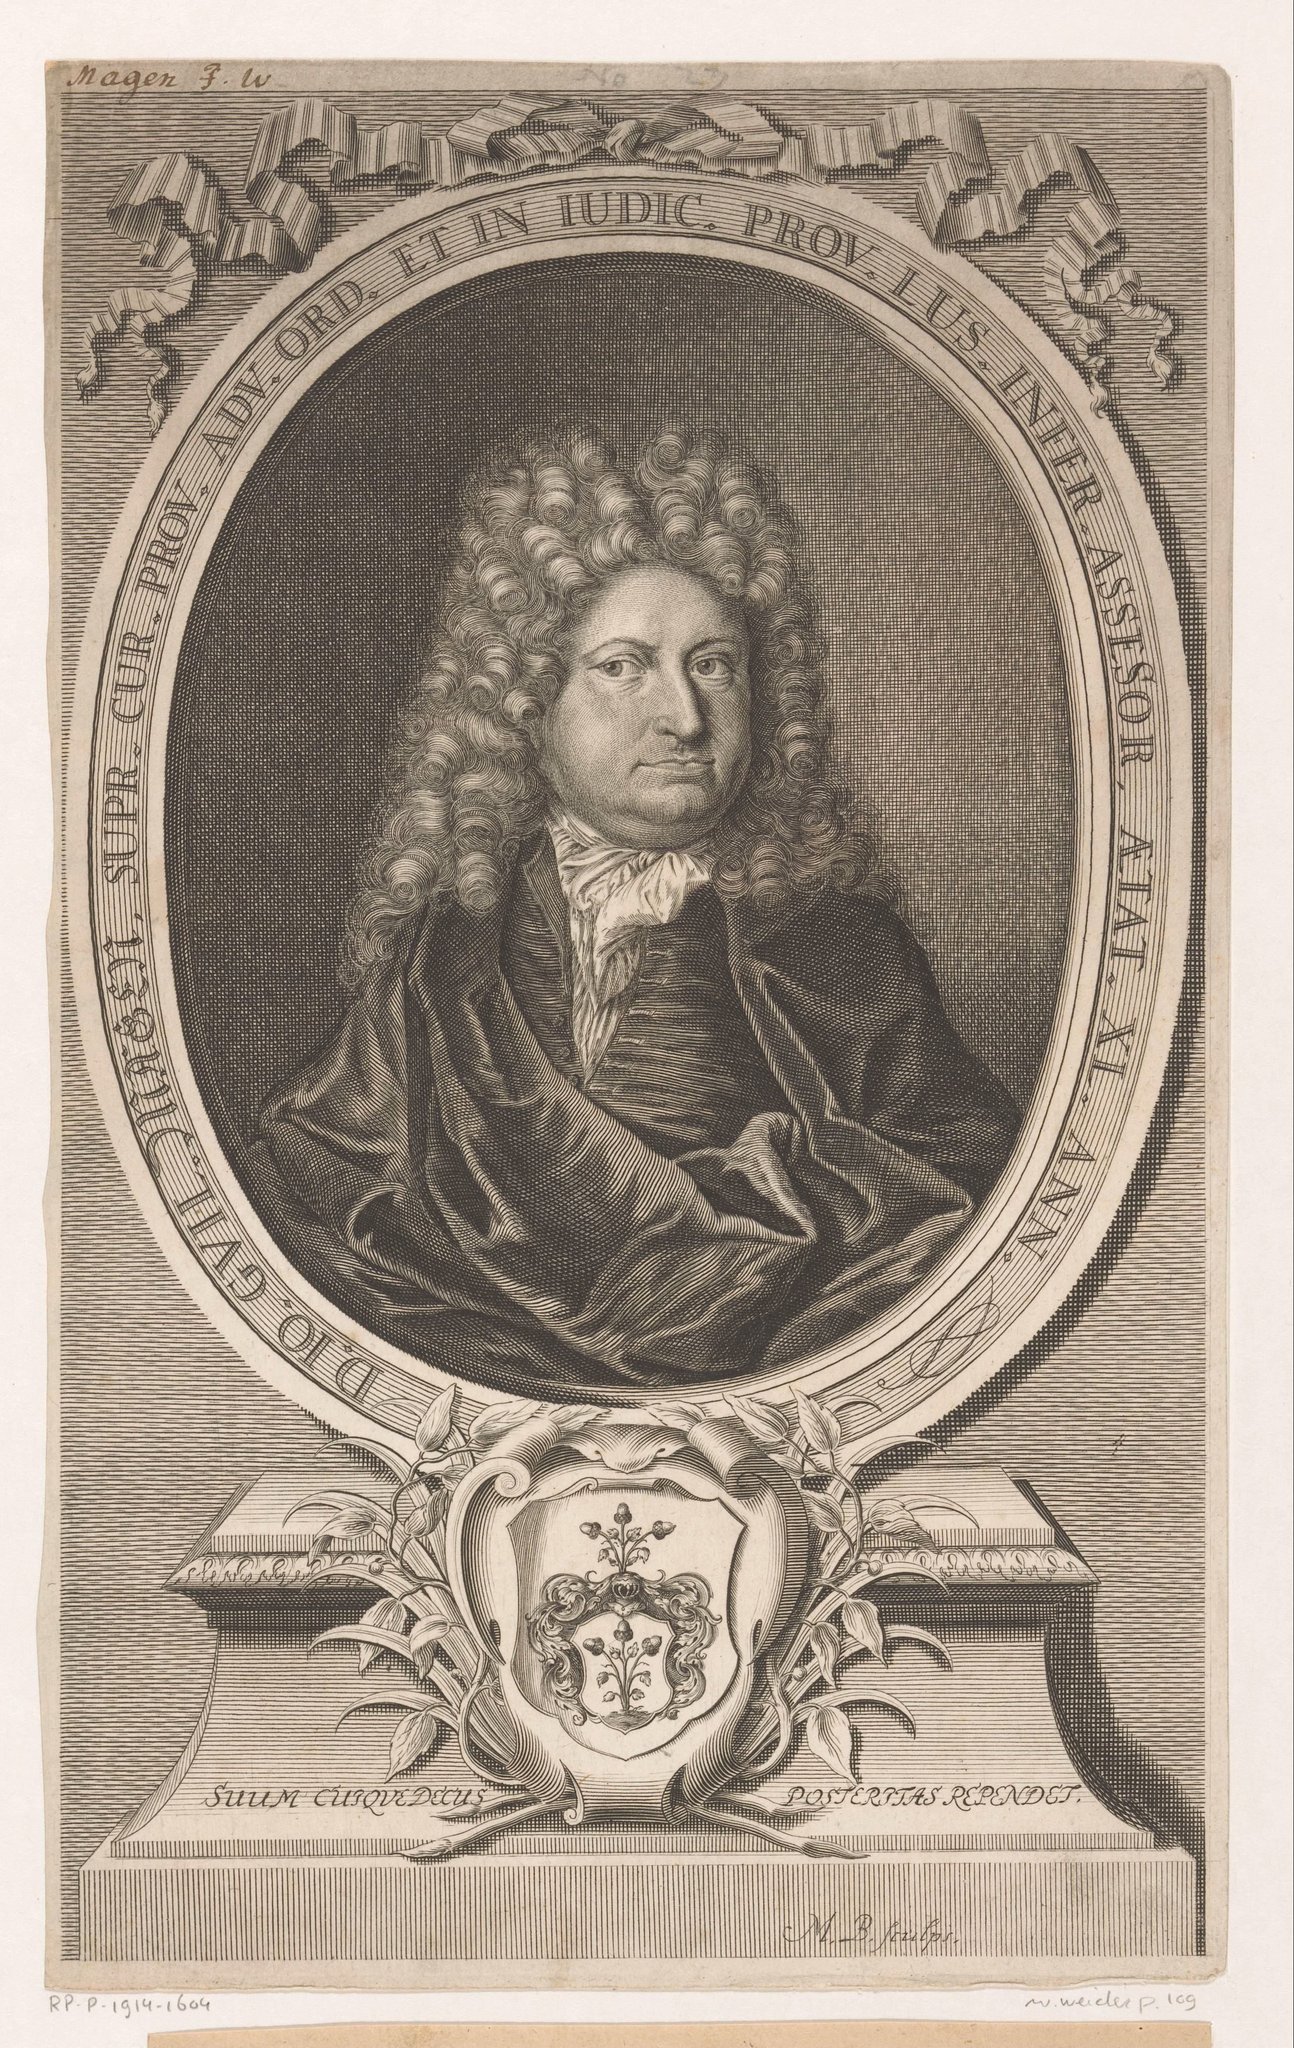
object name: print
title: Portret van Johann Wilhelm Magen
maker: johann martin bernigeroth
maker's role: print maker, publisher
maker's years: 1713-1767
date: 1695-1733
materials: paper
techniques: engraving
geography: leipzig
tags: historical persons, armorial bearing, heraldry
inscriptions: collector's mark: Lugt 2228